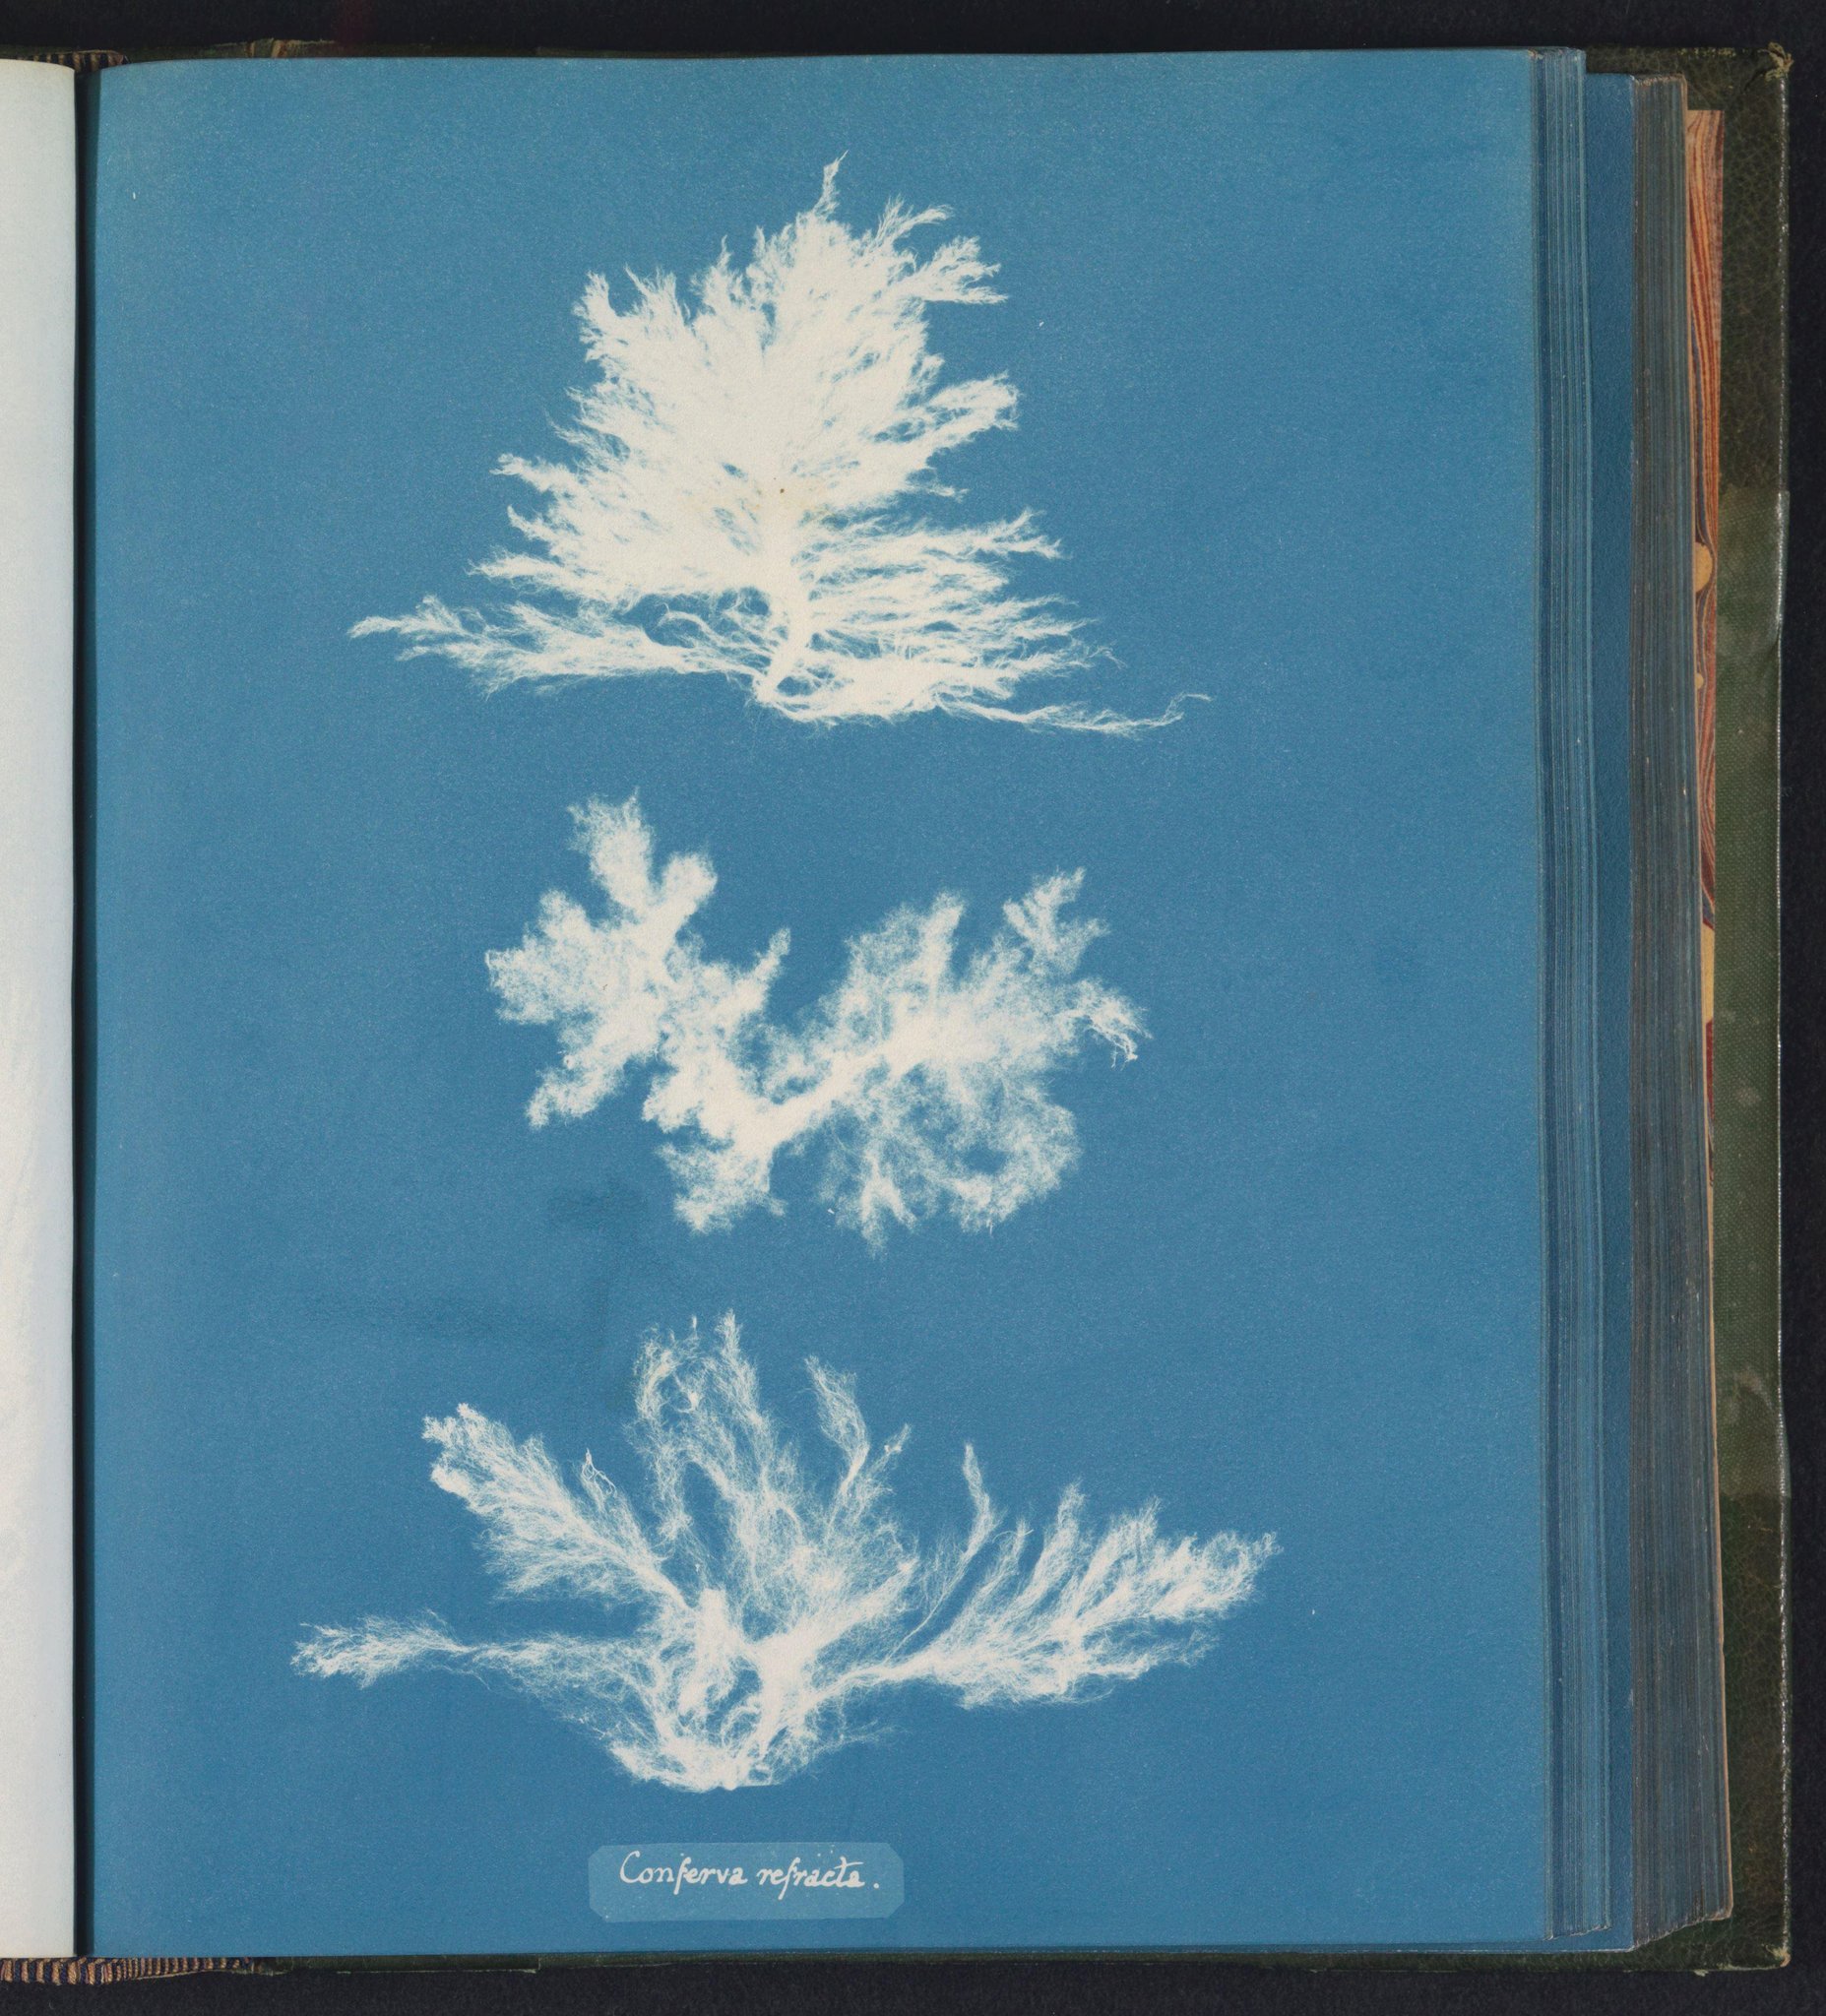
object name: photograph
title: Zeewier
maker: anna atkins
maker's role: fotograaf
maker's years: 1799-1871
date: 1843-1853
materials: photographic support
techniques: cyanotype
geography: united kingdom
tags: algae, seaweed